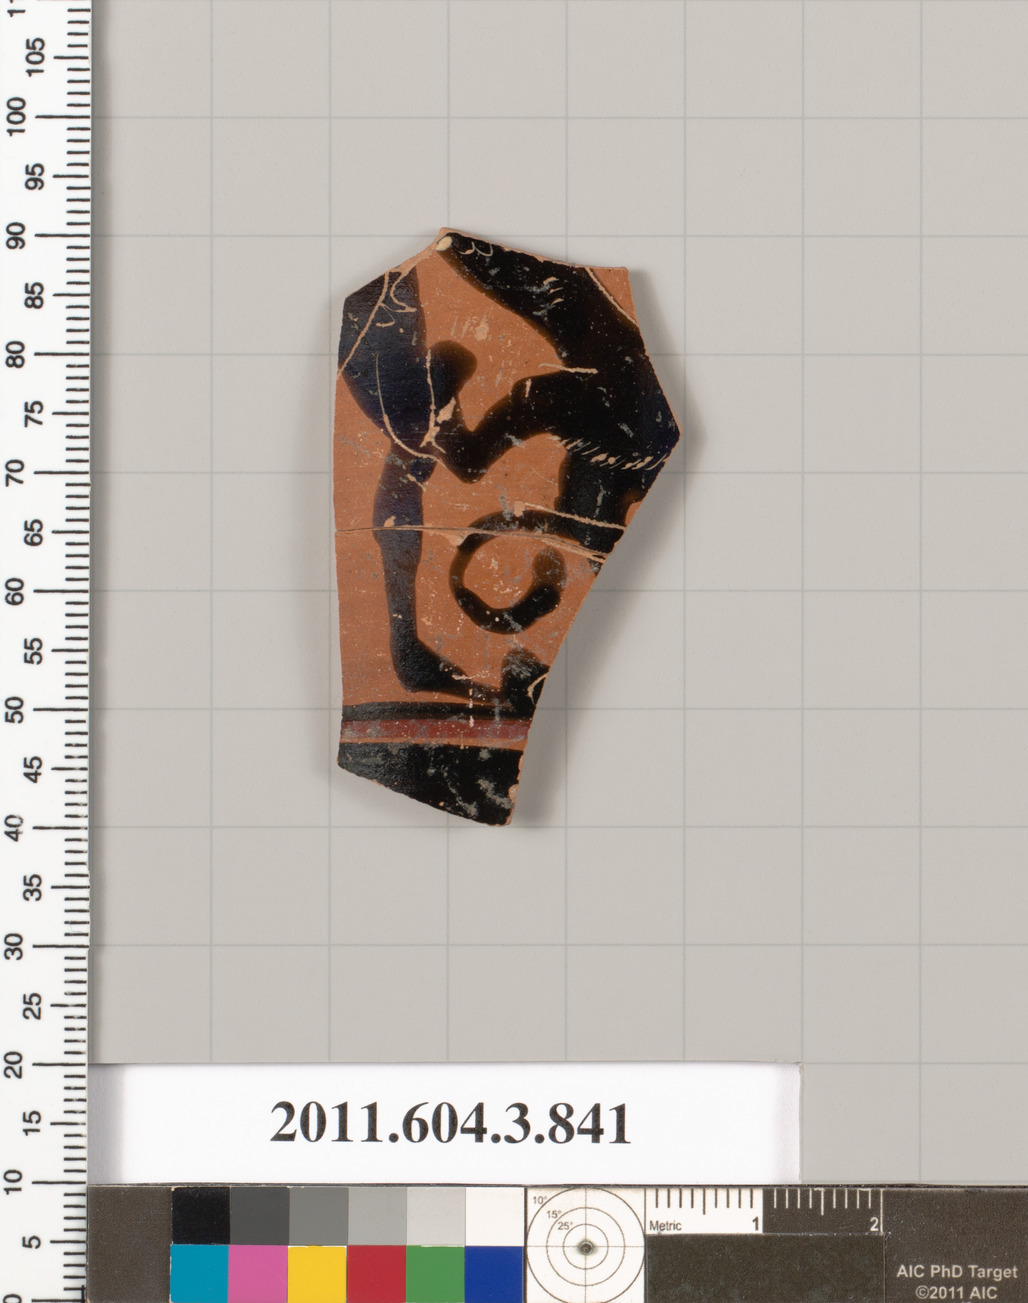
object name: lekythos fragment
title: Terracotta fragment of a lekythos (oil flask)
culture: greek, attic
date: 534-501 BCE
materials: terracotta